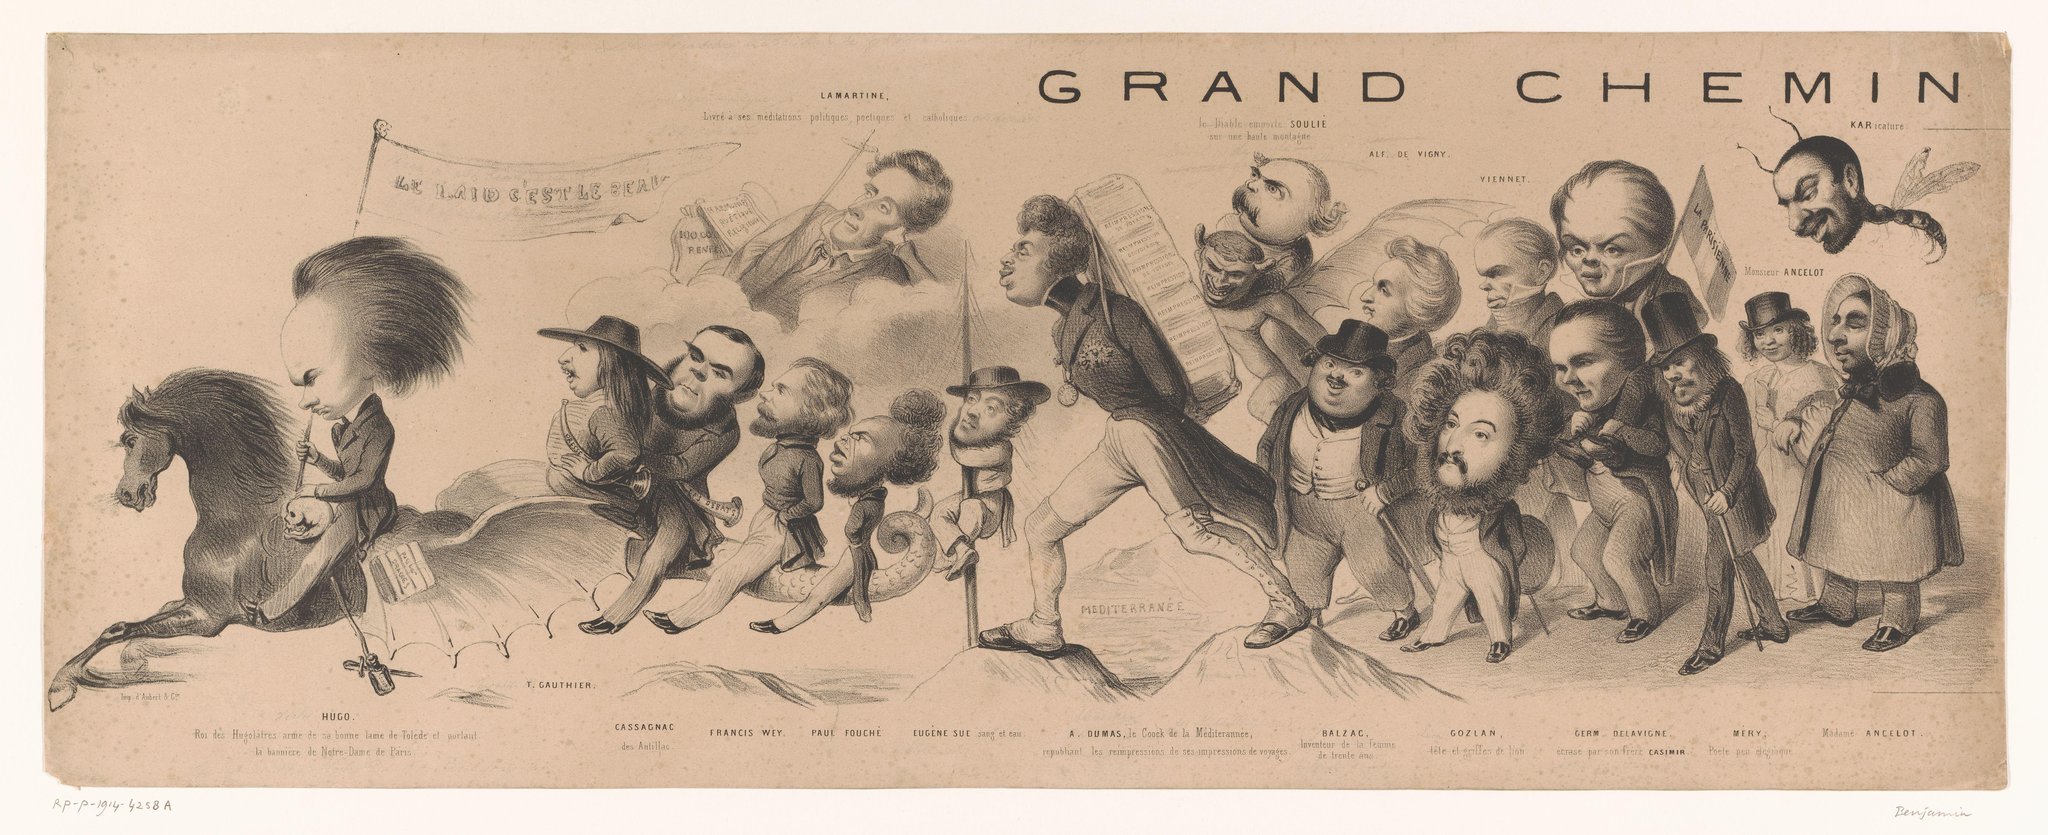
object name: book illustration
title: Grote weg naar het nageslacht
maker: benjamin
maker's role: print maker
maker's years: 1811-1847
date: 1842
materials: paper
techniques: lithograph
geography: paris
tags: victor hugo, caricatures (human types), historical persons, writer, poet, author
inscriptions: collector's mark: Lugt 2228a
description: Prent gebruikt voor: Roubaud, B. Grand chemin de la postérité: Les gens de lettres. Parijs: Aubert & Cie., 1840.